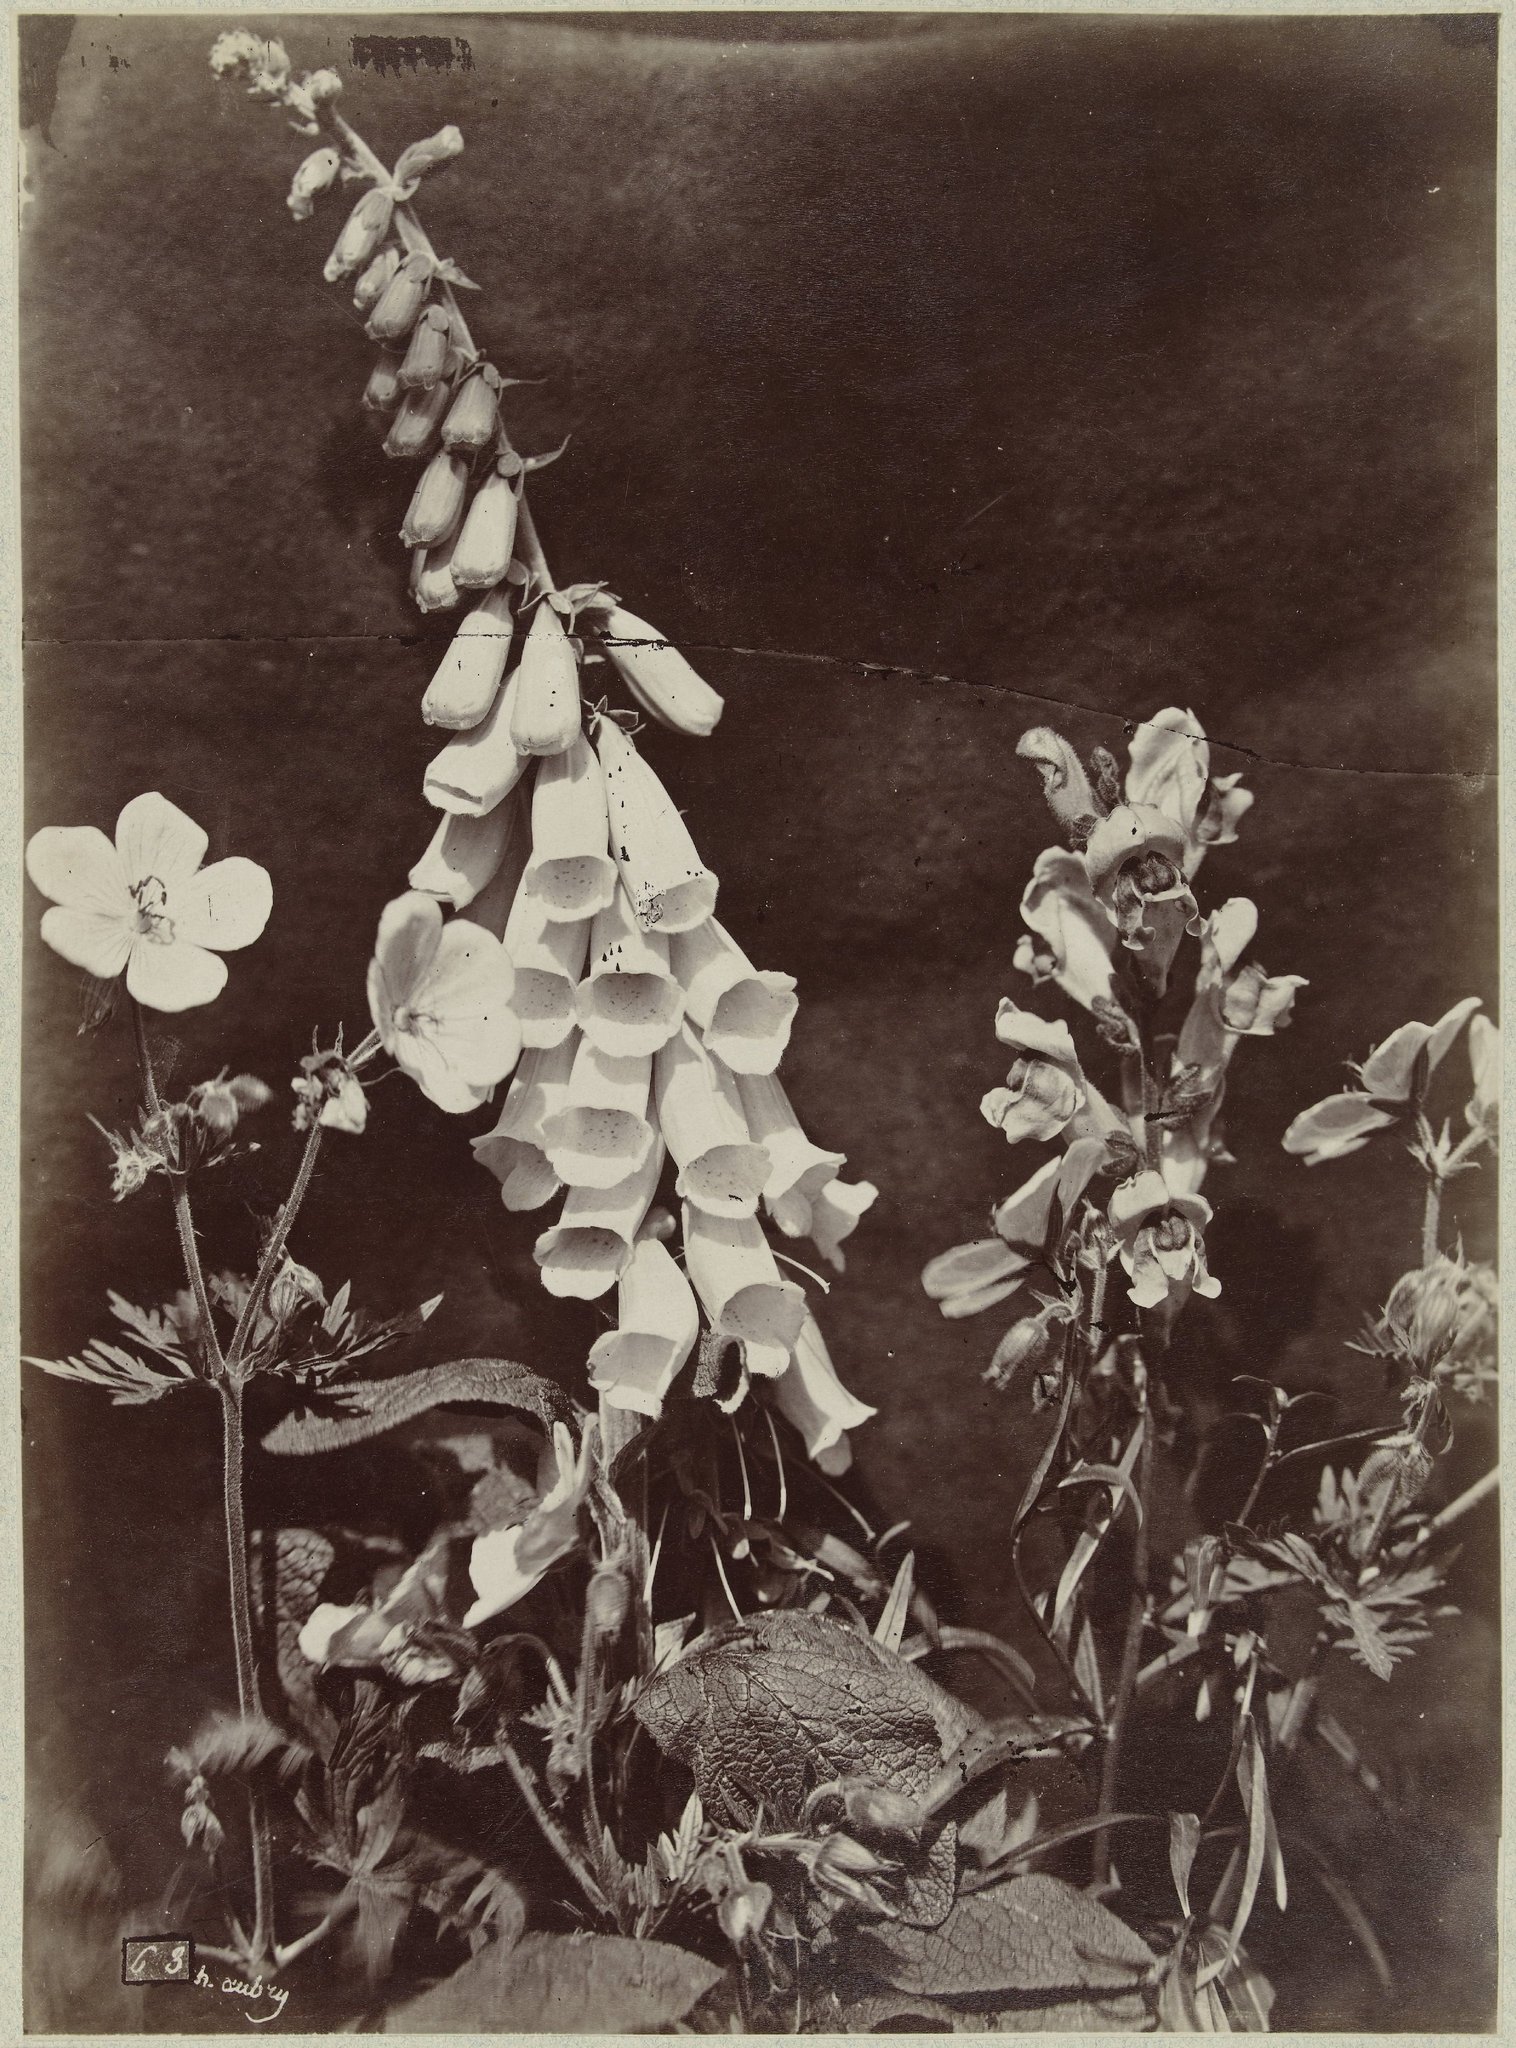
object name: photograph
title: Bloemstilleven met vingerhoedskruid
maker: charles aubry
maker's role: fotograaf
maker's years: 1811-1877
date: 1864-1872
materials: cardboard, paper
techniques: albumen print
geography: paris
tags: flowers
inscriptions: signature: ‘[c]h. aubry’, number: ‘63’, inscription: ‘Kl 3/ XII/ Pl 9’, inscription: ‘Digitalis (MB)’, collector's mark: Lugt 3937